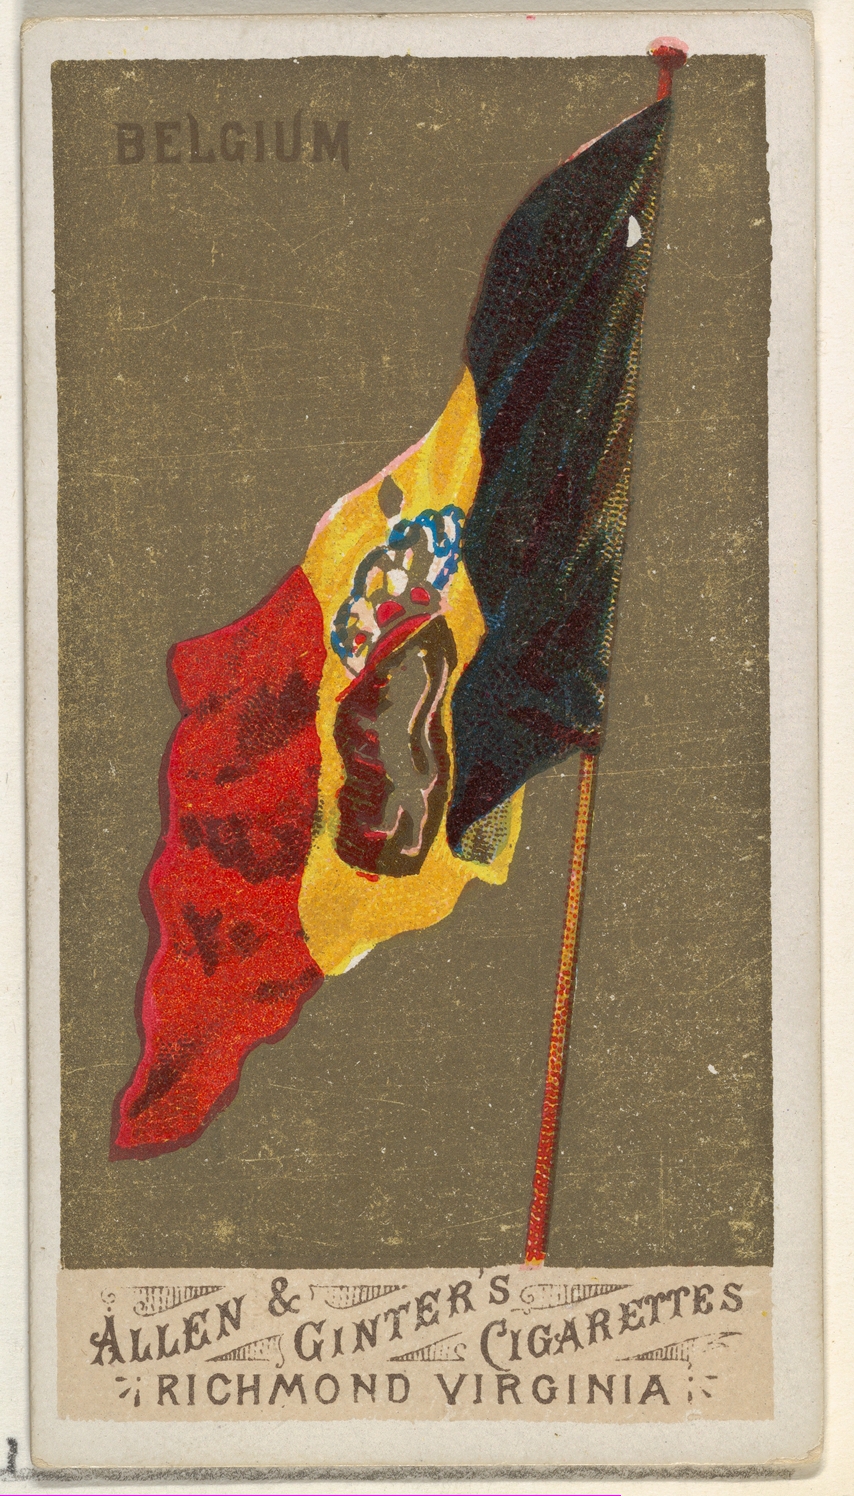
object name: print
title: Belgium, from Flags of All Nations, Series 1 (N9) for Allen & Ginter Cigarettes Brands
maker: allen & ginter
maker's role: publisher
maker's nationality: american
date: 1887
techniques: color lithograph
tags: coat of arms,flags